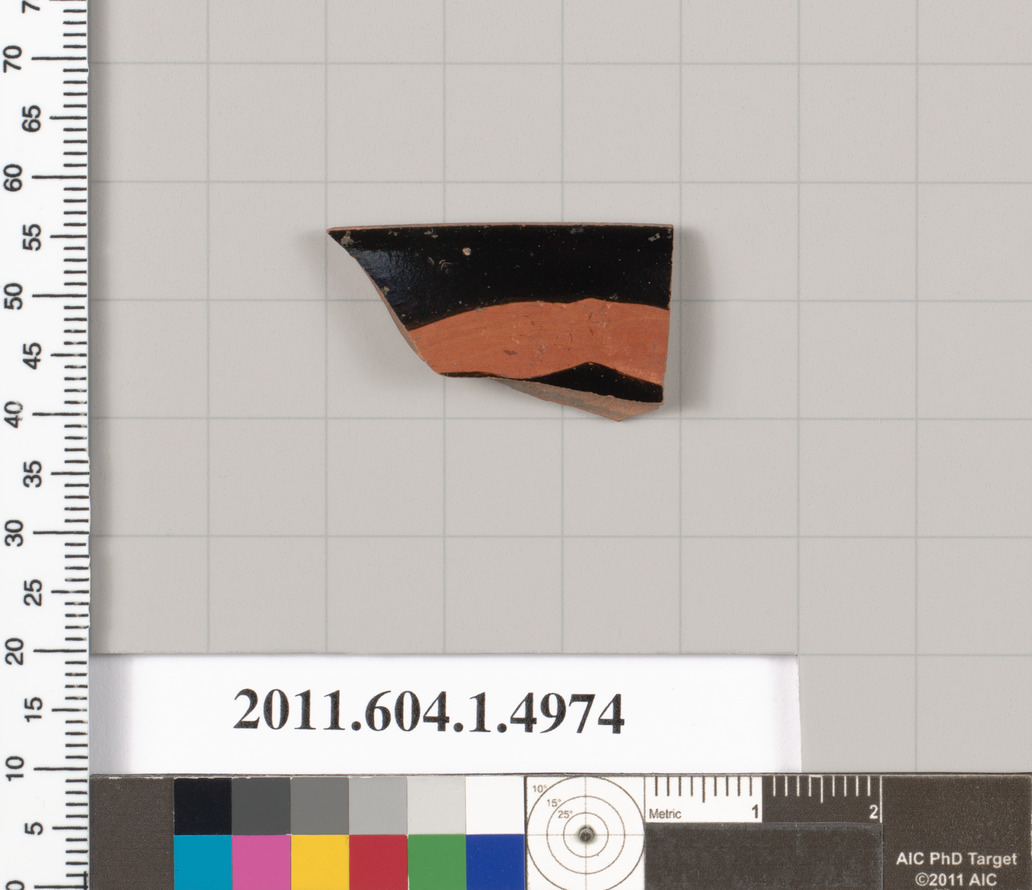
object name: kylix fragment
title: Terracotta rim fragment of a kylix (drinking cup)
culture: greek, attic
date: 490-480 BCE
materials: terracotta